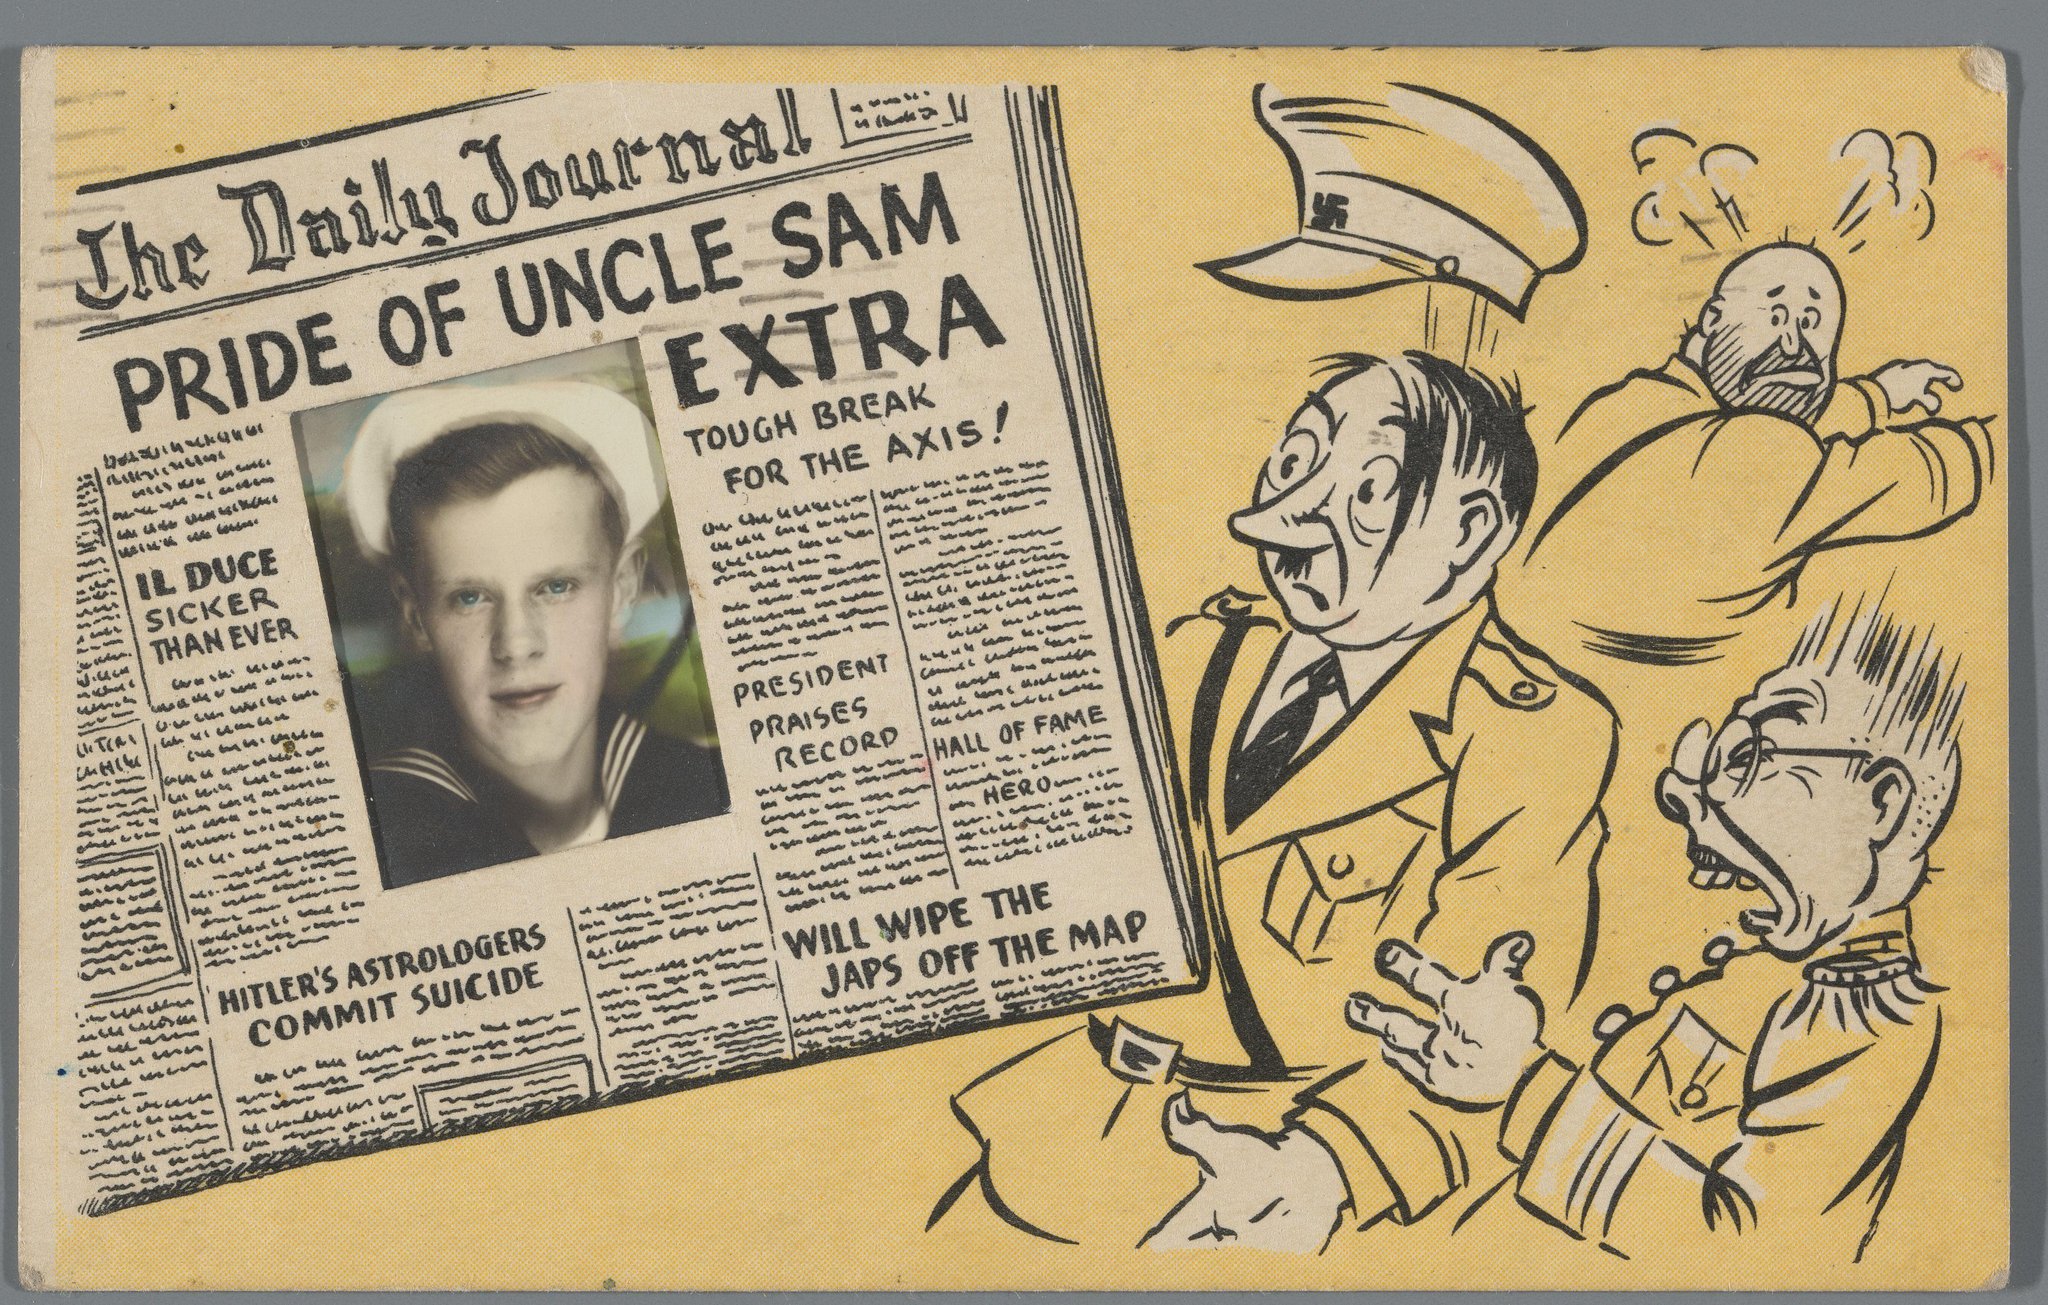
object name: ansichtkaart, prentbriefkaart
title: William Swanson, matroos, gestationeerd in Naval Training Station (USNTS Sampson)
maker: Anonymous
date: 1944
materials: photographic support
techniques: gelatin silver print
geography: united states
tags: william swanson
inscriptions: inscription: ‘GENEVA, N.Y. / OCT. 16 / 6 – PM / 1944’, inscription: ‘Wim Swanson 5 2/C [?] / 609-85-89 / D.G U – L- [?] / USNTS / Sampson NY // Miss Jpoyce [?] Sheldon / 57 Barriet Ave / Jamestown N.Y.’